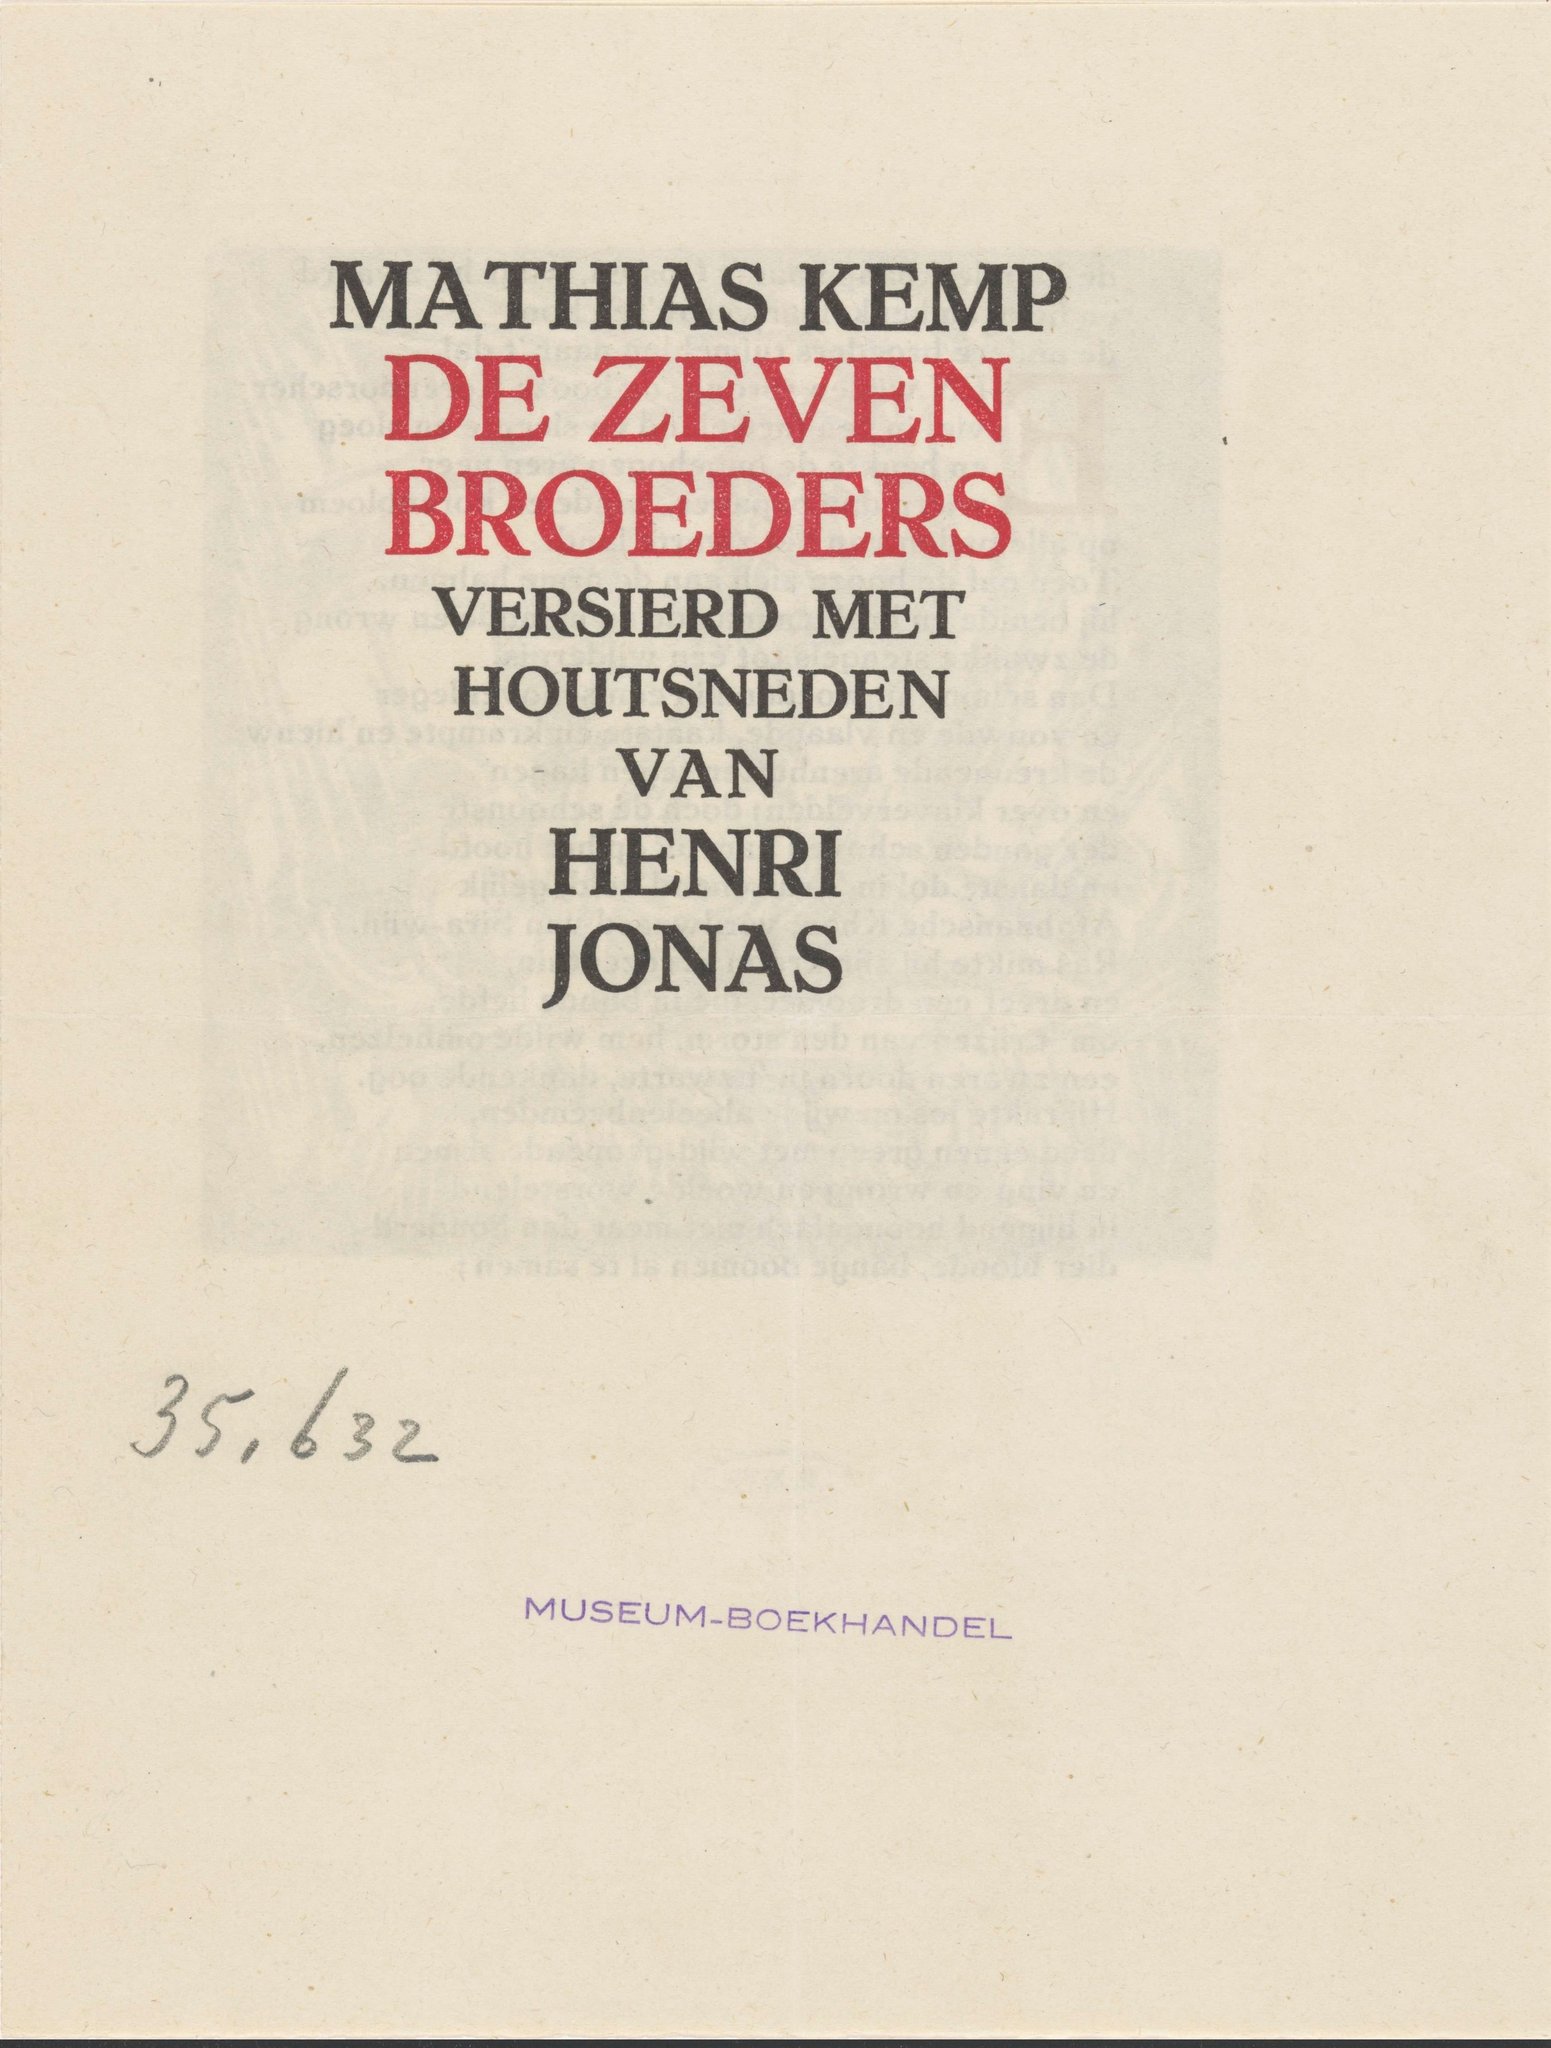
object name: folder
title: Reclamefolder voor De zeven broeders van Mathias Kemp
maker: henri jonas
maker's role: draughtsman, print maker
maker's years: 1878-1944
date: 1921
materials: paper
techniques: woodcut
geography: maastricht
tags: winds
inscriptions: collector's mark: Lugt 2228, collector's mark: Lugt 2760, stamp: ‘MUSEUM-BOEKHANDEL’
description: Op verso een houtsnede van Henri Jonas. Een man, een personificatie van de wind, kijkt vanuit de wolken naar boven.